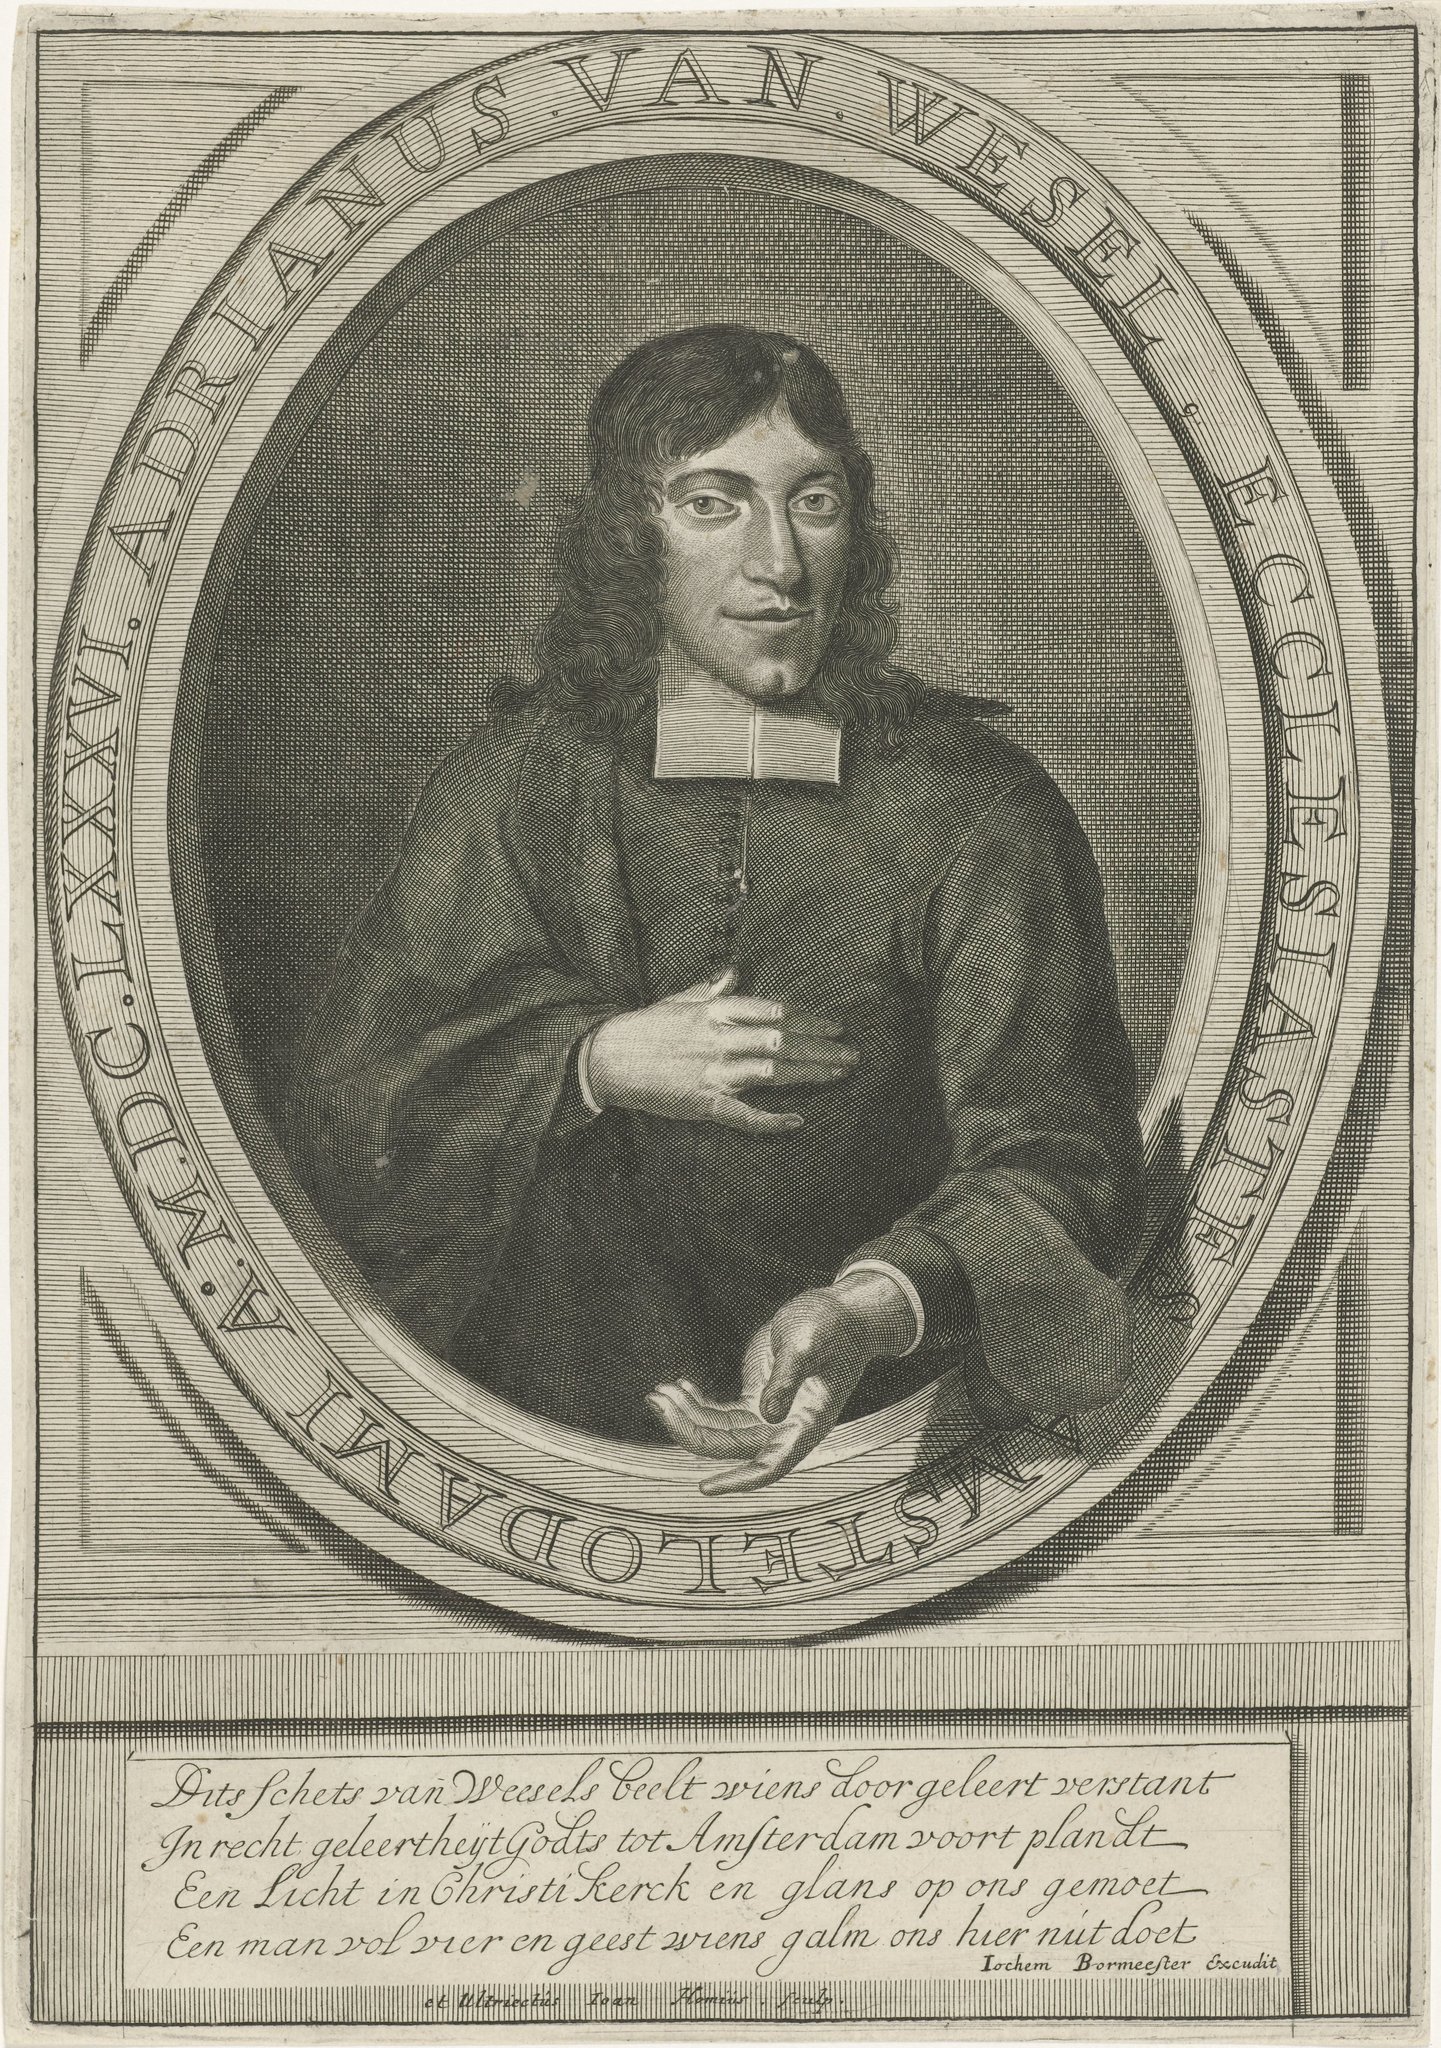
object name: print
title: Portret van Adriaan Wesel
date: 1686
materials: paper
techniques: engraving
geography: amsterdam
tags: predikant, theoloog, adriaan wesel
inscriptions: collector's mark: Lugt 2228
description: Portret ten halven lijve van de Amsterdamse predrikant Adriaan Wesel in een ovaal met randschrift in het Latijn. Onder het portret vier regels in het Nederlands.